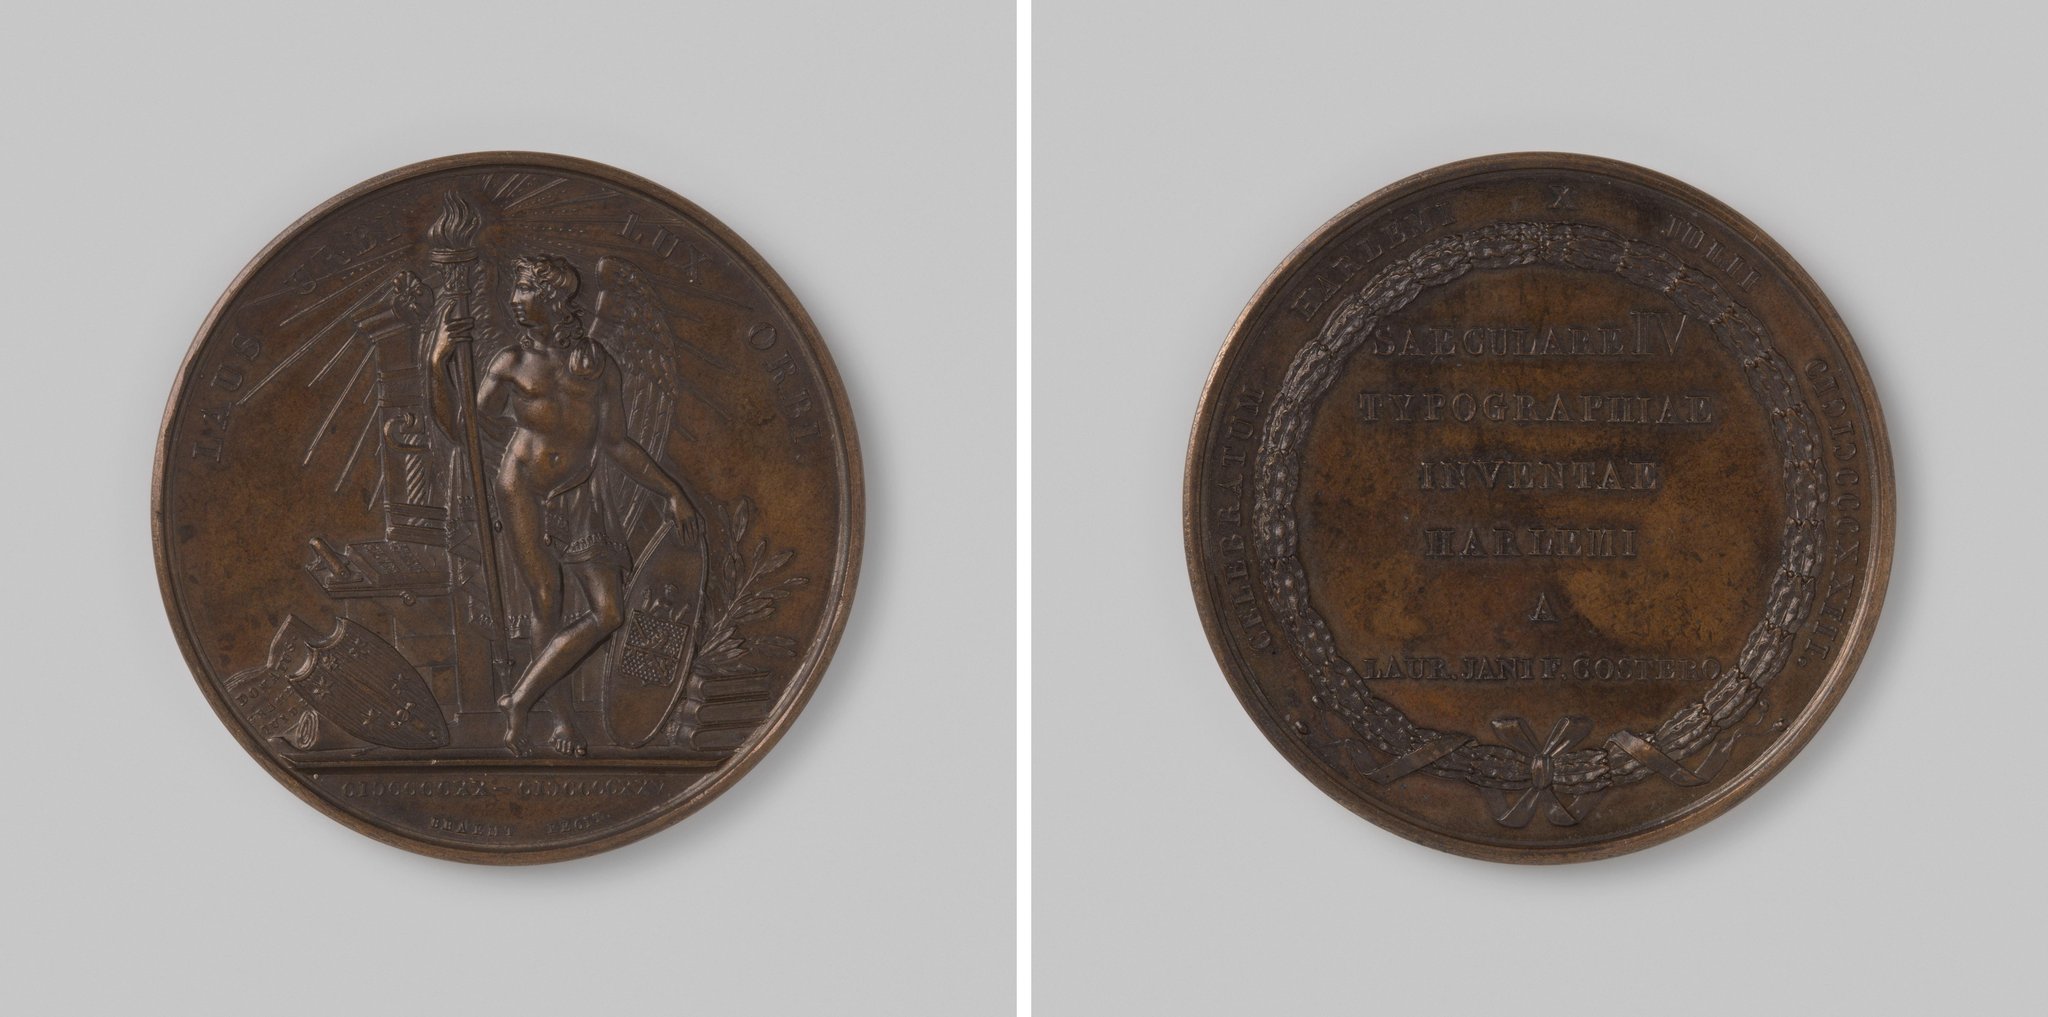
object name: history medal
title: Vierhonderdjarige herdenking van de uitvinding van de boekdrukkunst door Laurens Coster te Haarlem 1823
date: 1823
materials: bronze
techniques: striking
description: Bronzen penning, op de voorzijde een genius met toorts tussen een drukpers en boeken naast een Haarlems wapenschild, met omschrift en afsnedetekst, op de keerzijde zes regels tekst binnen een lauwerkrans, met omschrift.